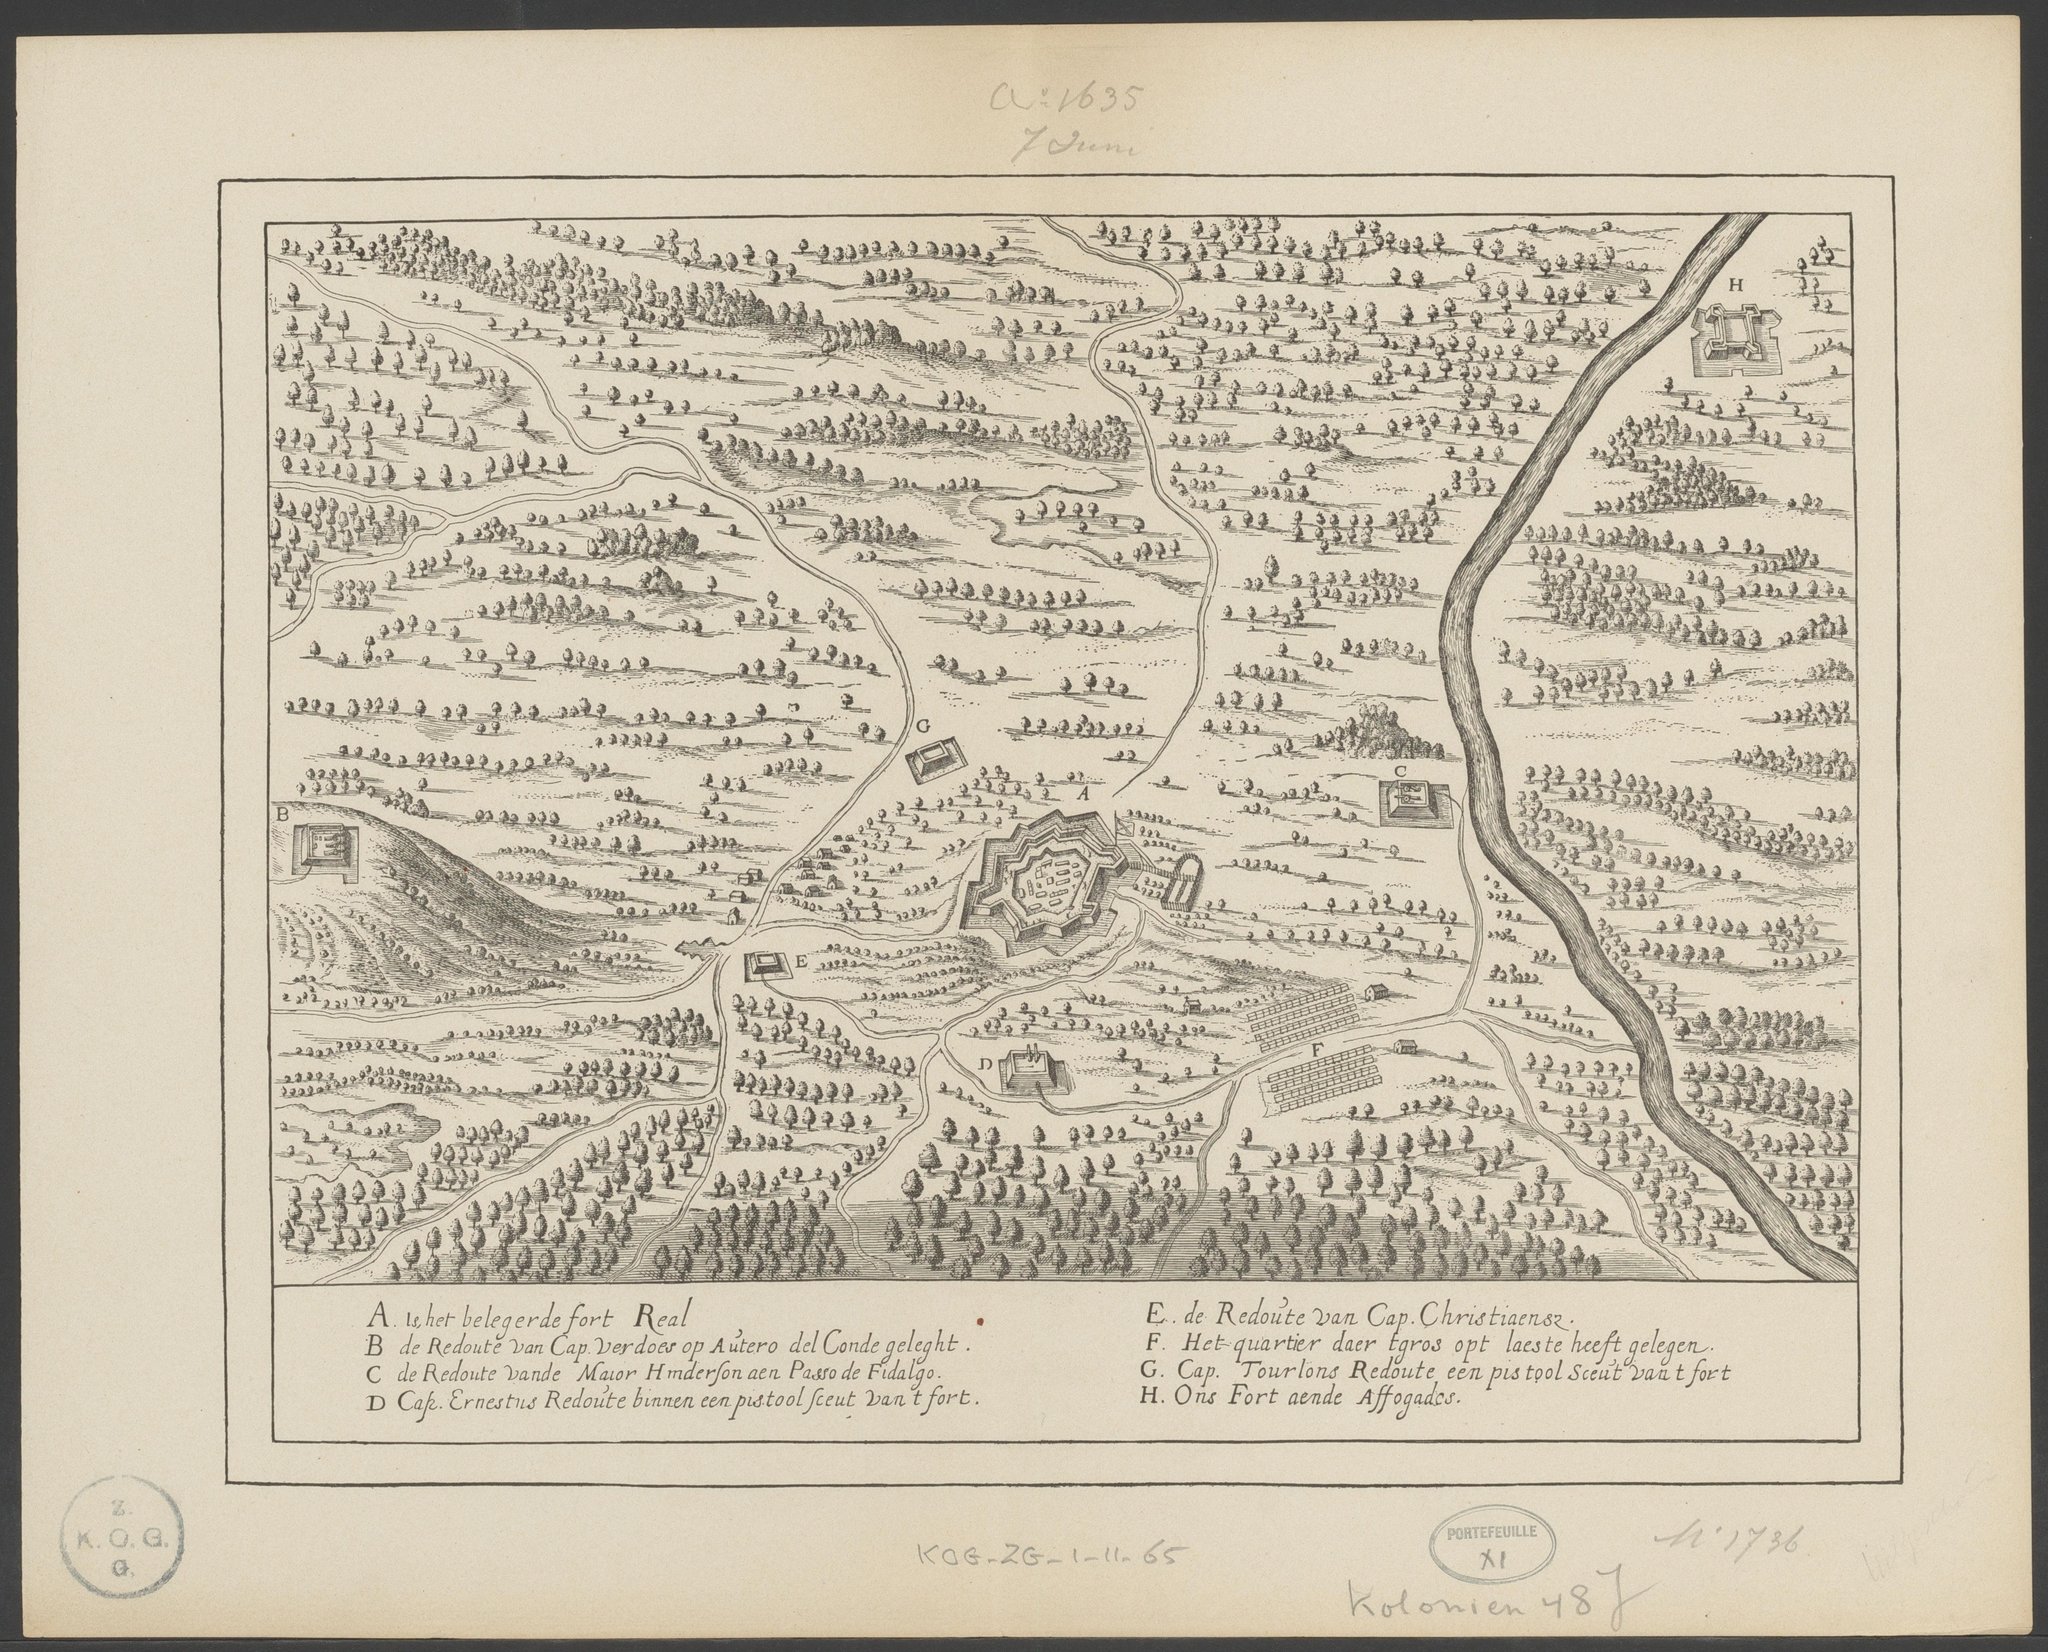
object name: print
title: Fort Real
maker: Anonymous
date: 1800-1899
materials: paper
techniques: lithograph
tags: harbour, fortress, brasil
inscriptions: collector's mark: Lugt 1641, stamp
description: Onderaan een legenda van A tot H. Onderwerpsrubrieken binnen de Atlas Zeden en Gewoonten: Handel, nijverheid en verkeer, Koophandel, Veilingen, Makelaardij en Verzekeringswezen. Kamers te huur.